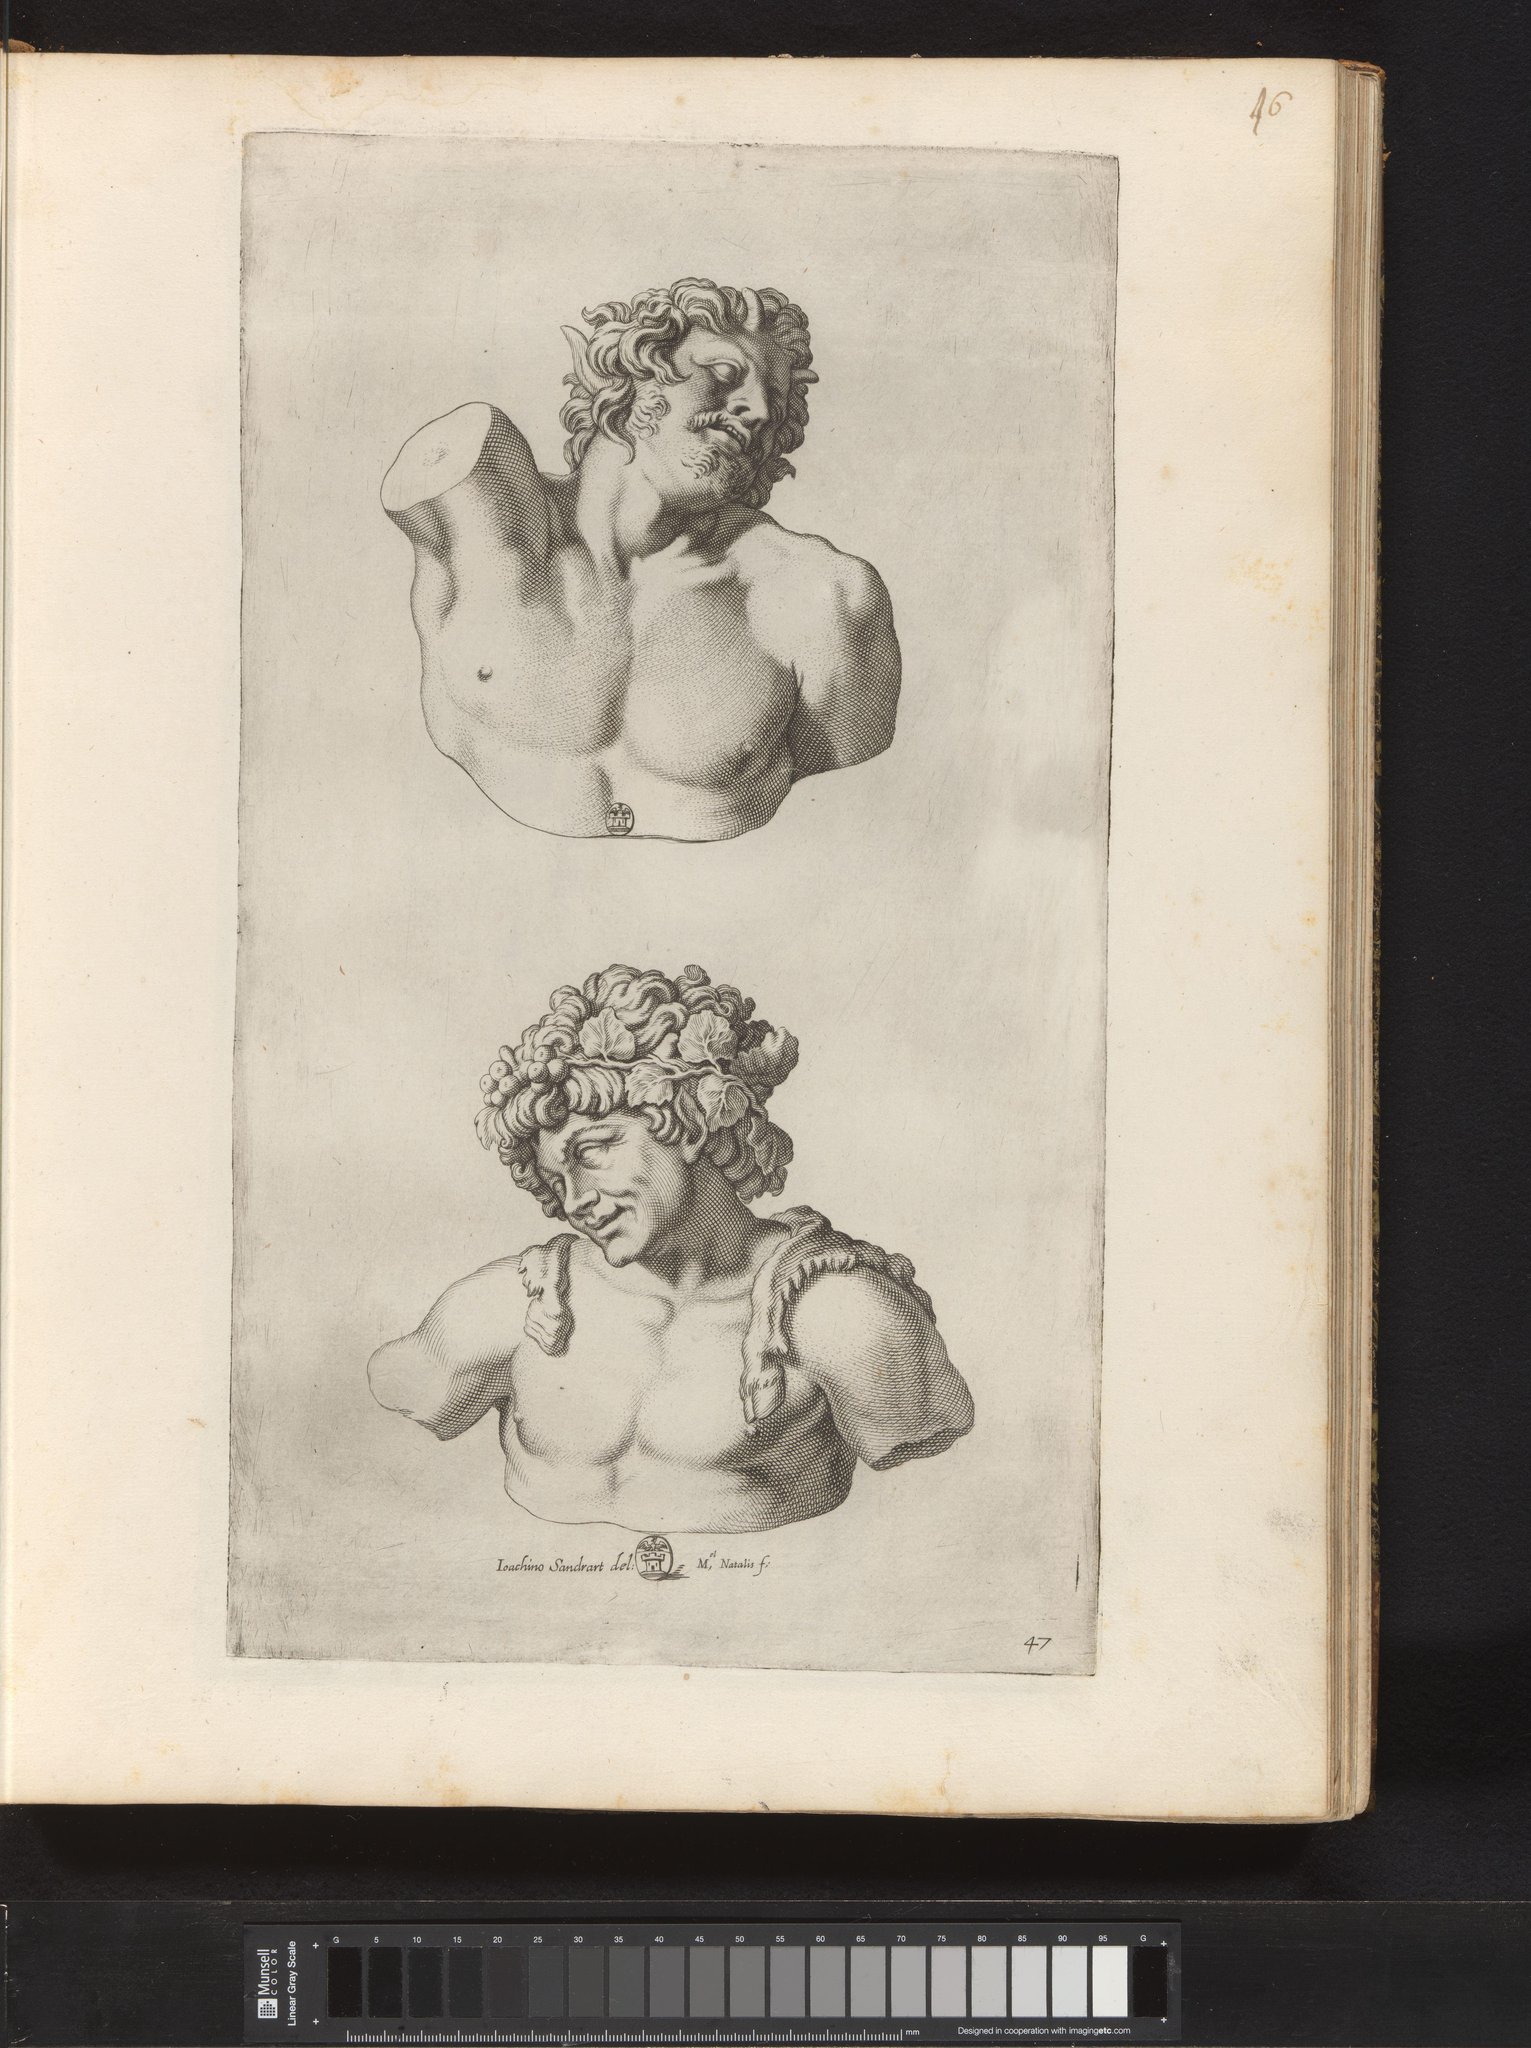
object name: print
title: Galleria Giustiniana del Marchese Vincenzo Giustiniani II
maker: michel natalis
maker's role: print maker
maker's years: 1610-1668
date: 1636-1647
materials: paper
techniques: engraving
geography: rome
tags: satyrs, fauns, sileni, piece of sculpture, reproduction of a piece of sculpture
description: Twee bustes van de jonge Medusa. De bovenste met wingerdbladeren in het haar,de onderste met vleugels in het haar. Op de onderste bustes het wapenschild van Vincenzo Giustiniani. Prent maakt deel uit van een album met een serie prenten naar de sculpturen in de verzameling in de Galleria Giustiniani te Rome.